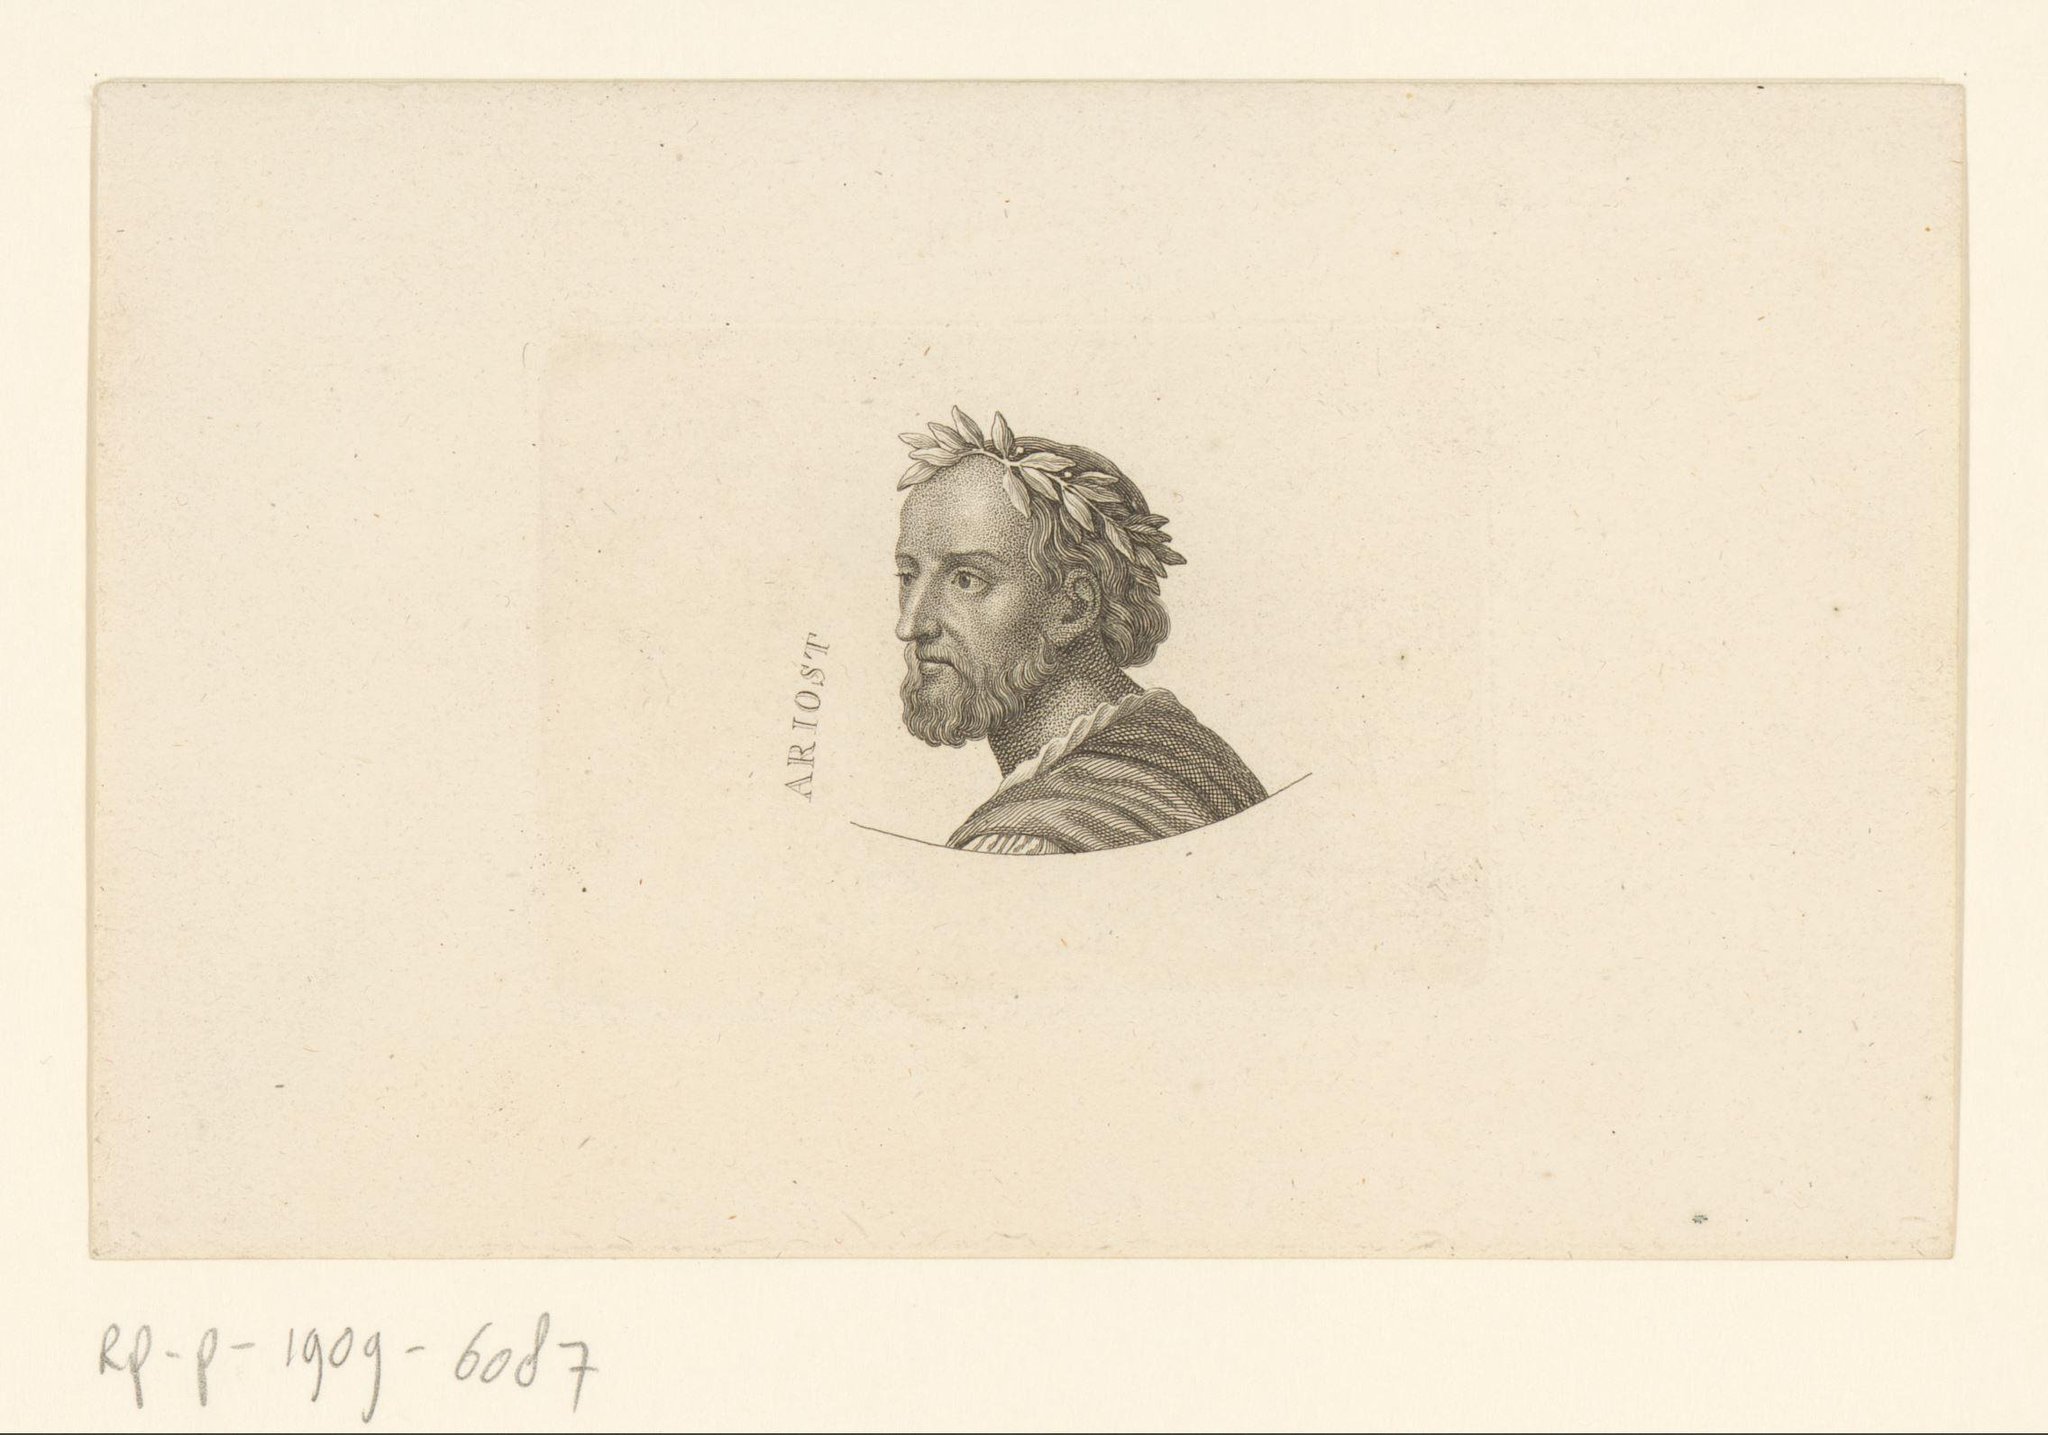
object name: print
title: Portret van Francesco Petrarca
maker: ernst ludwig riepenhausen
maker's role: print maker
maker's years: 1765-1840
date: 1775-1840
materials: paper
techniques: etching, engraving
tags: francesco petrarca, honouring the artist with laurel wreath, historical persons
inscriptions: collector's mark: Lugt 2228